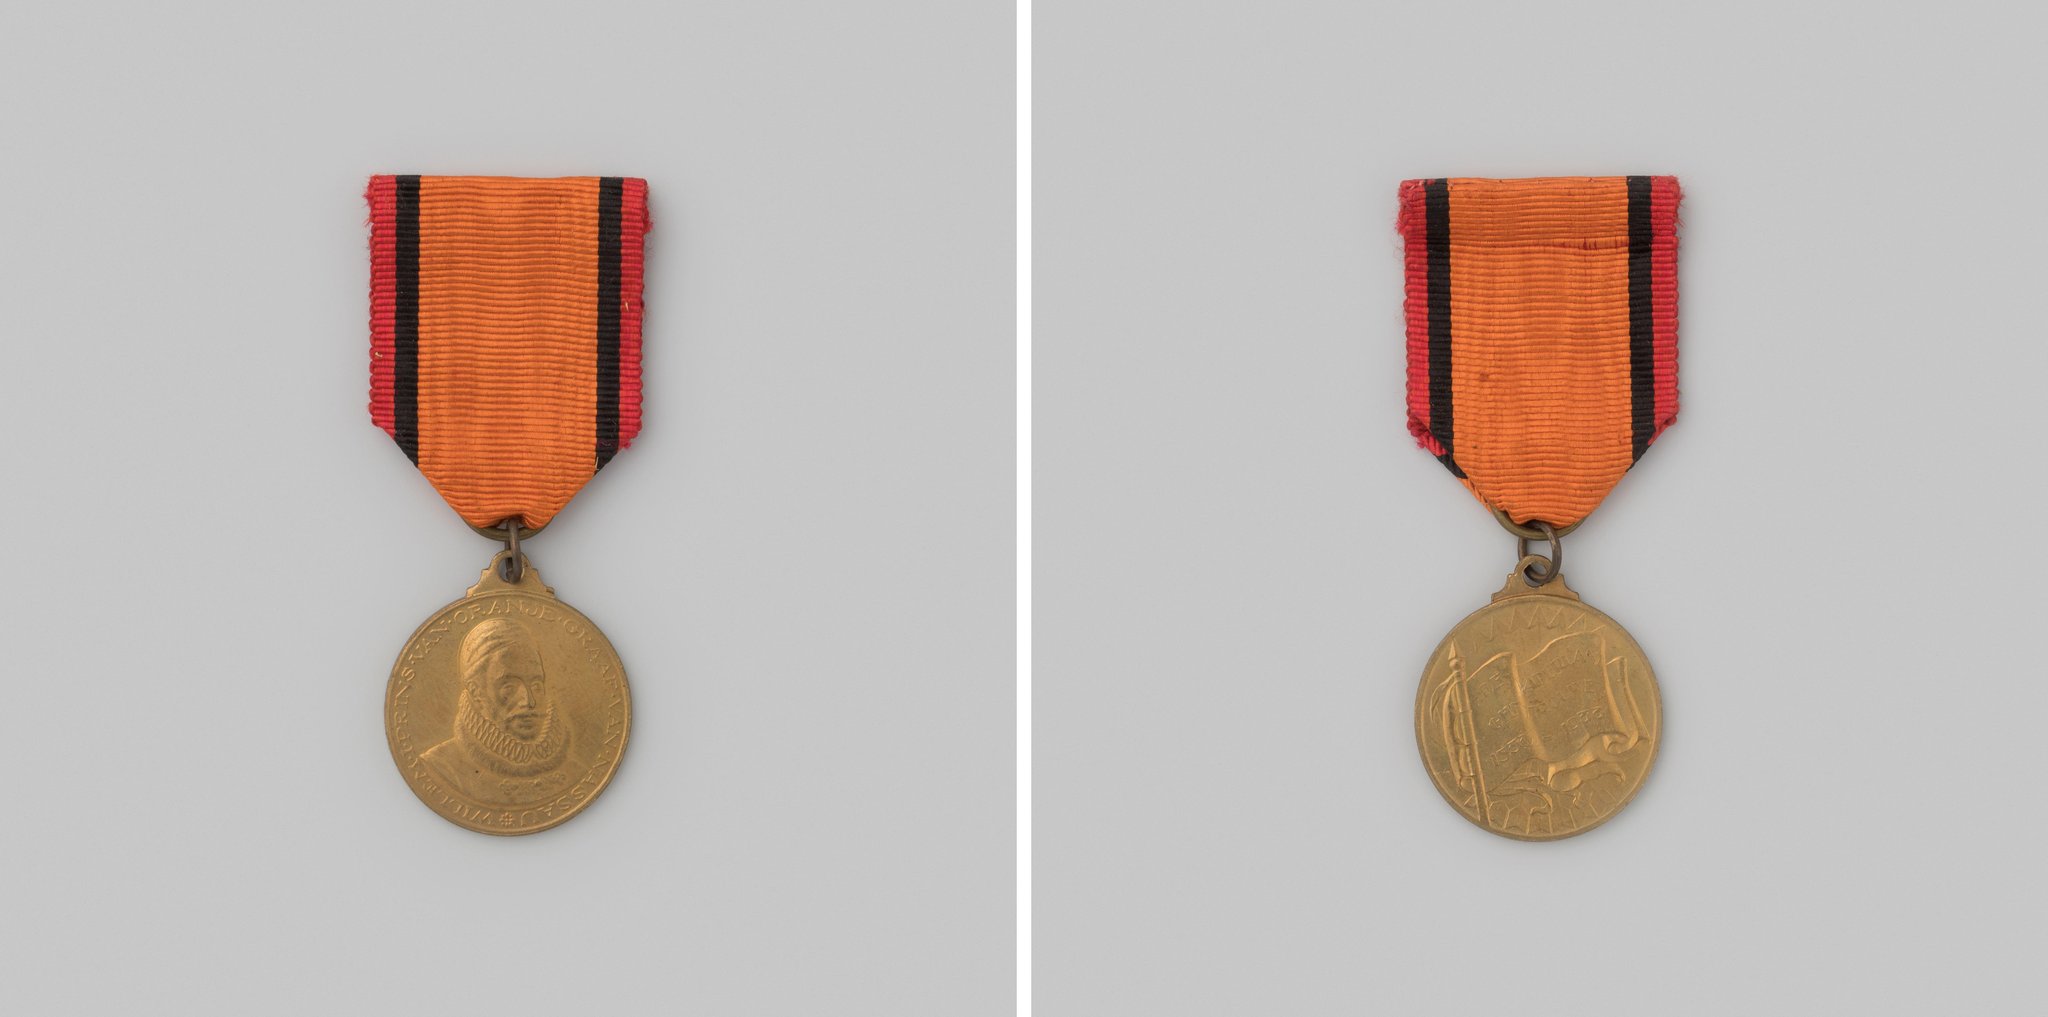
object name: medal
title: Herinneringspenning met beeltenis en opschrift betreffende Willem Prins van Oranje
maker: Anonymous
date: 1884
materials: metal, textile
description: Metalen draagpenning met oog, ring en lint.